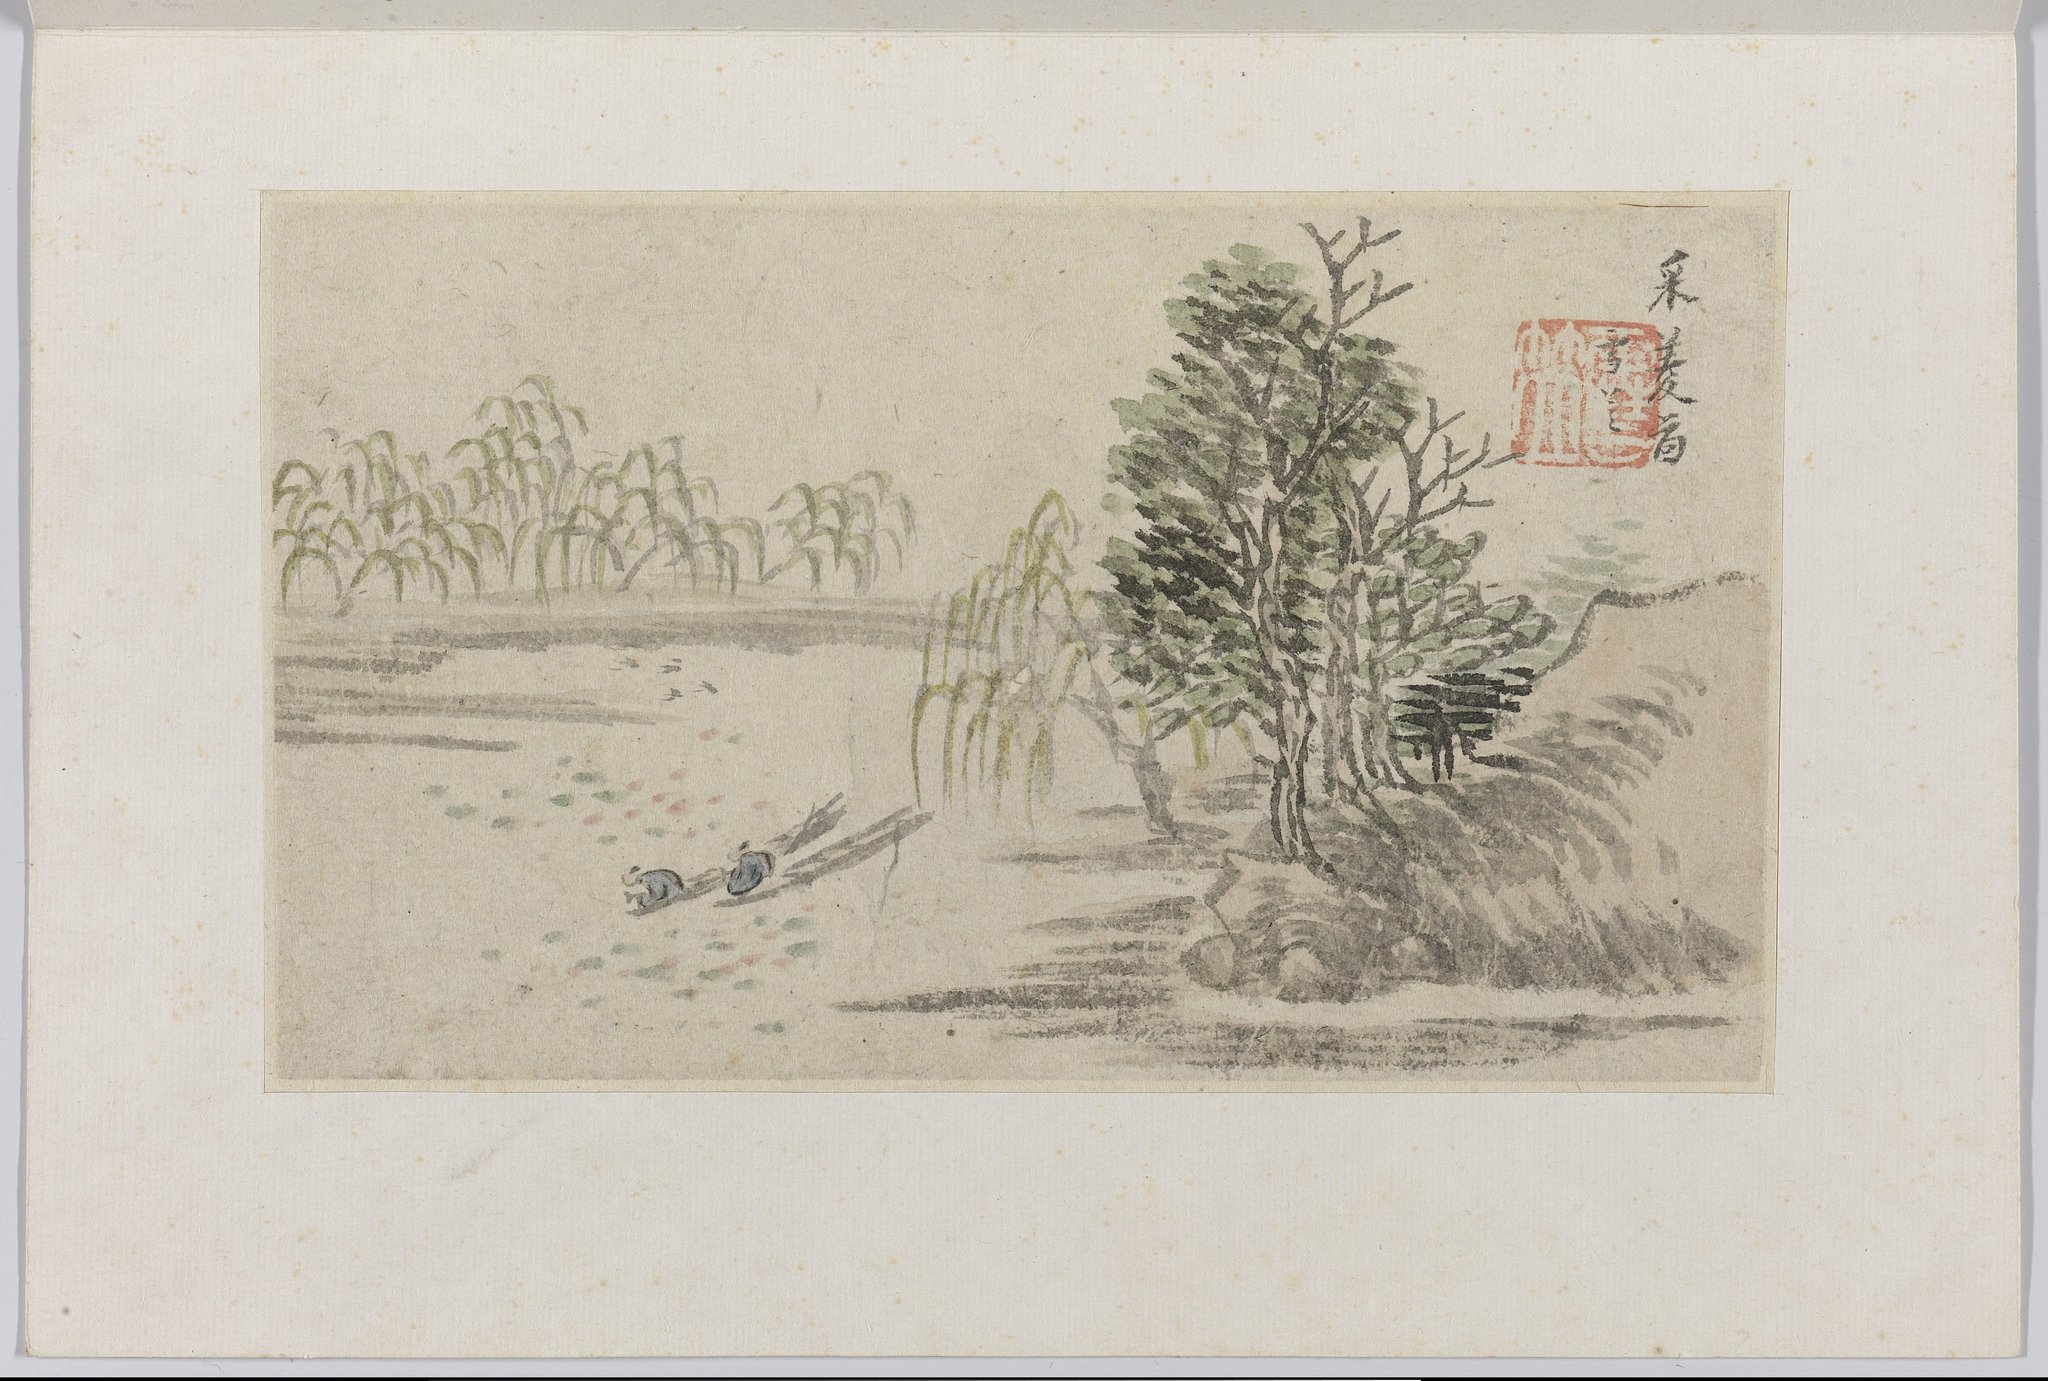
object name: album leaf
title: Landschap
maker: cheng men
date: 1850-1900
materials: ink, paper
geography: china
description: Albumblad met een landschap. Gesigneerd door Cheng Men, bekend als porseleinschilder in Jingdezhen.